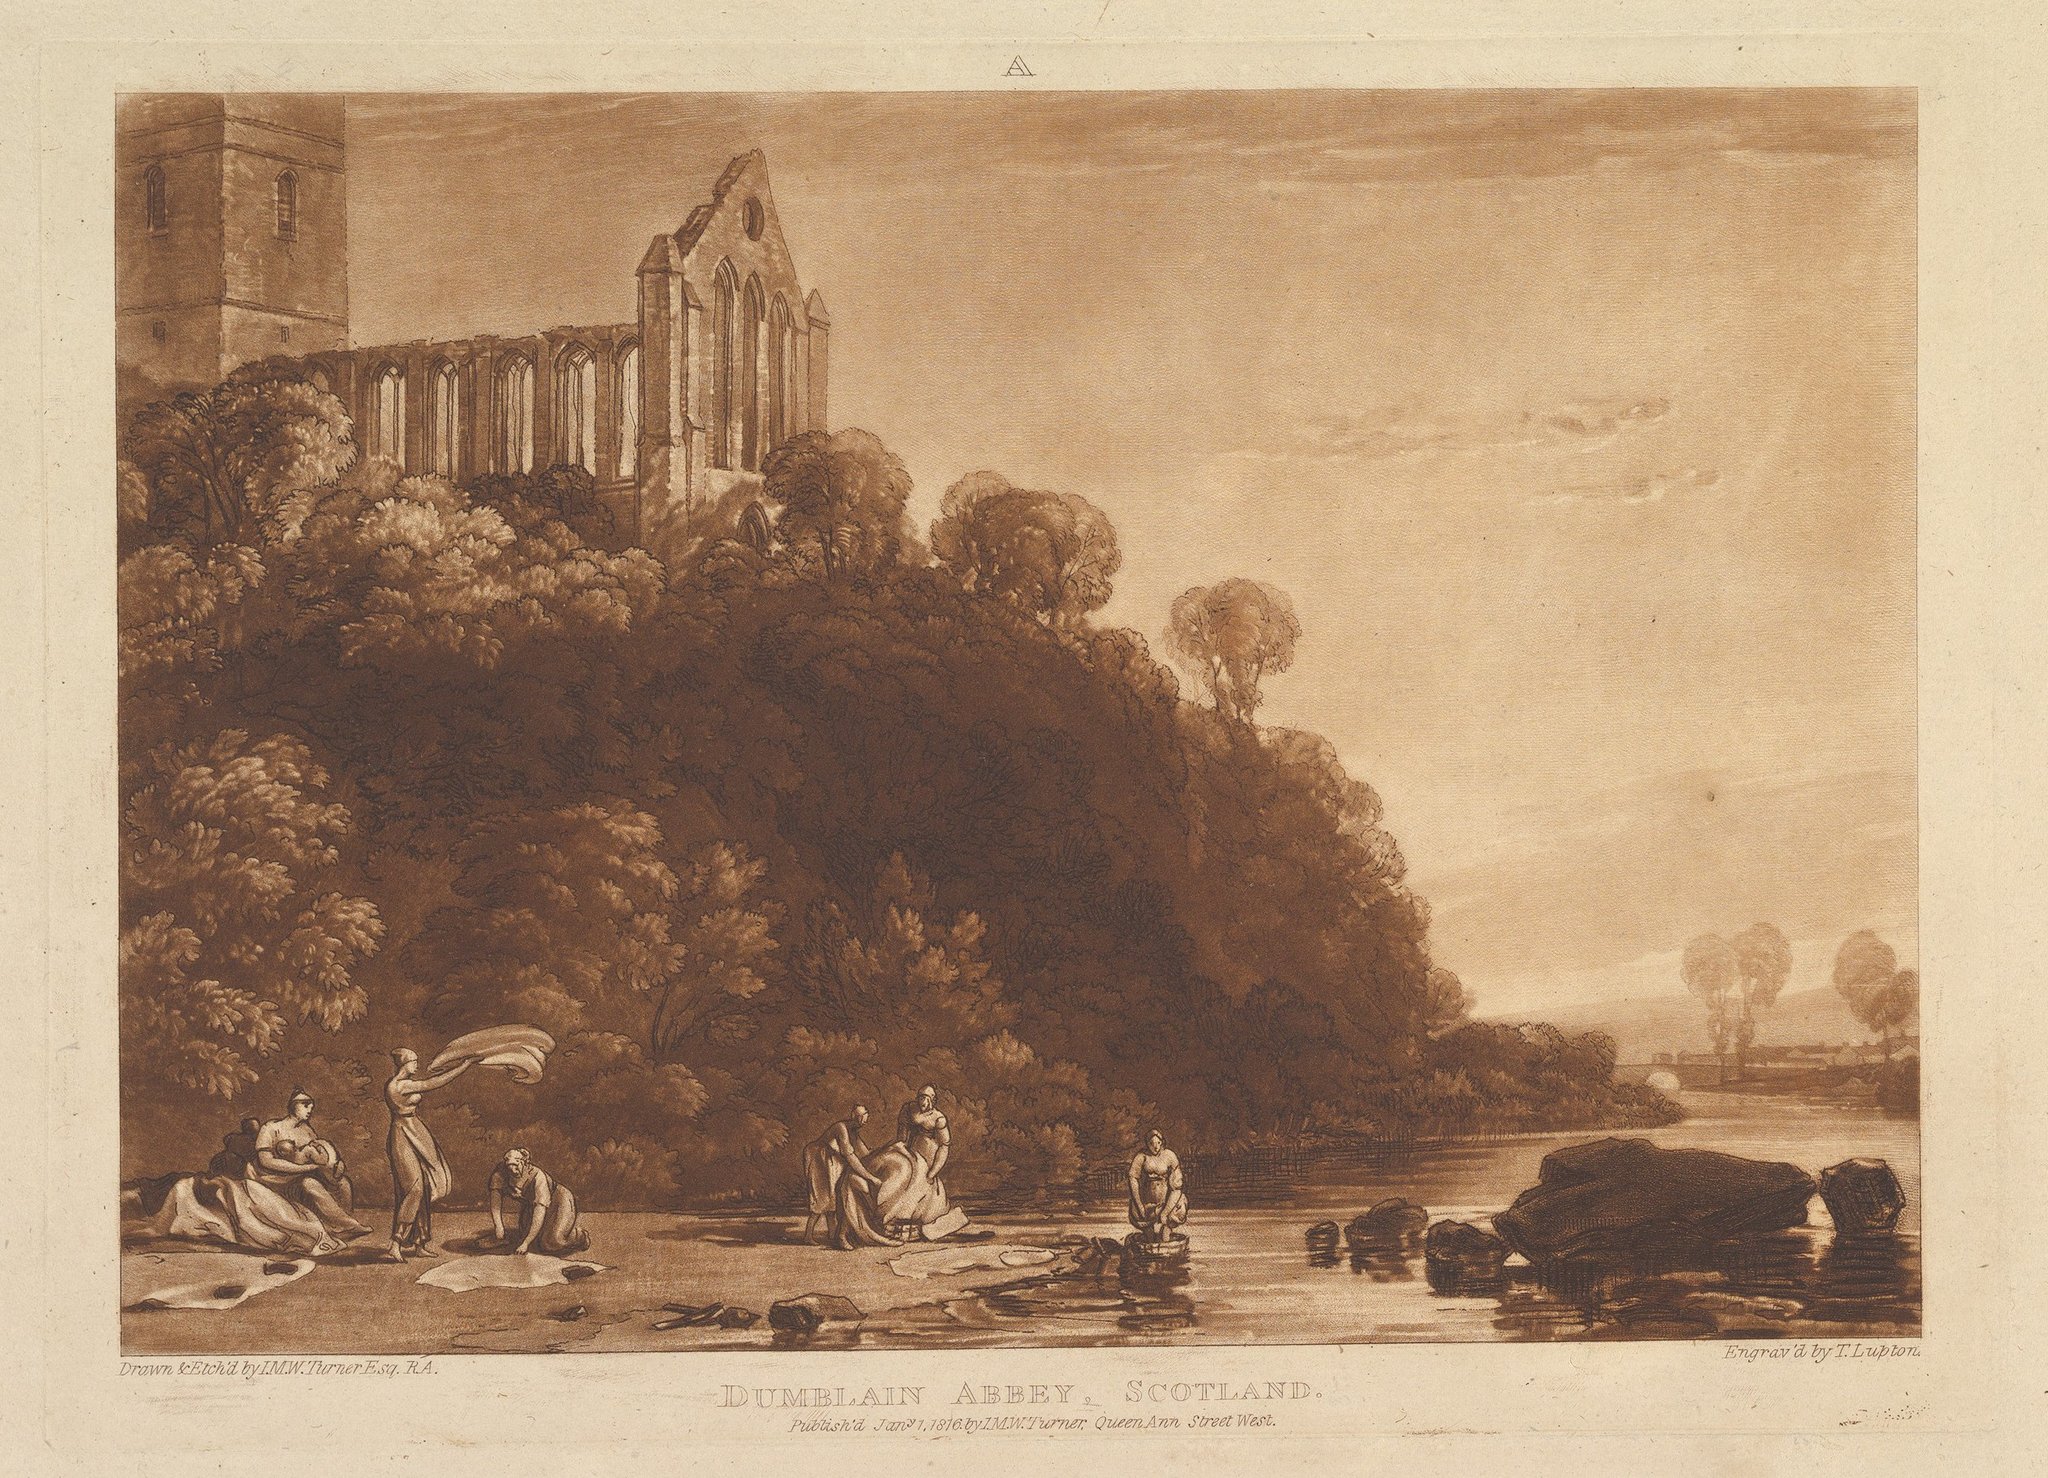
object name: print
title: Dumblain Abbey, Scotland, part XI, plate 56 from "Liber Studiorum"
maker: joseph mallord william turner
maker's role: artist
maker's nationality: british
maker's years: 1775-1851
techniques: etching, mezzotint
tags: abbeys,women,washing